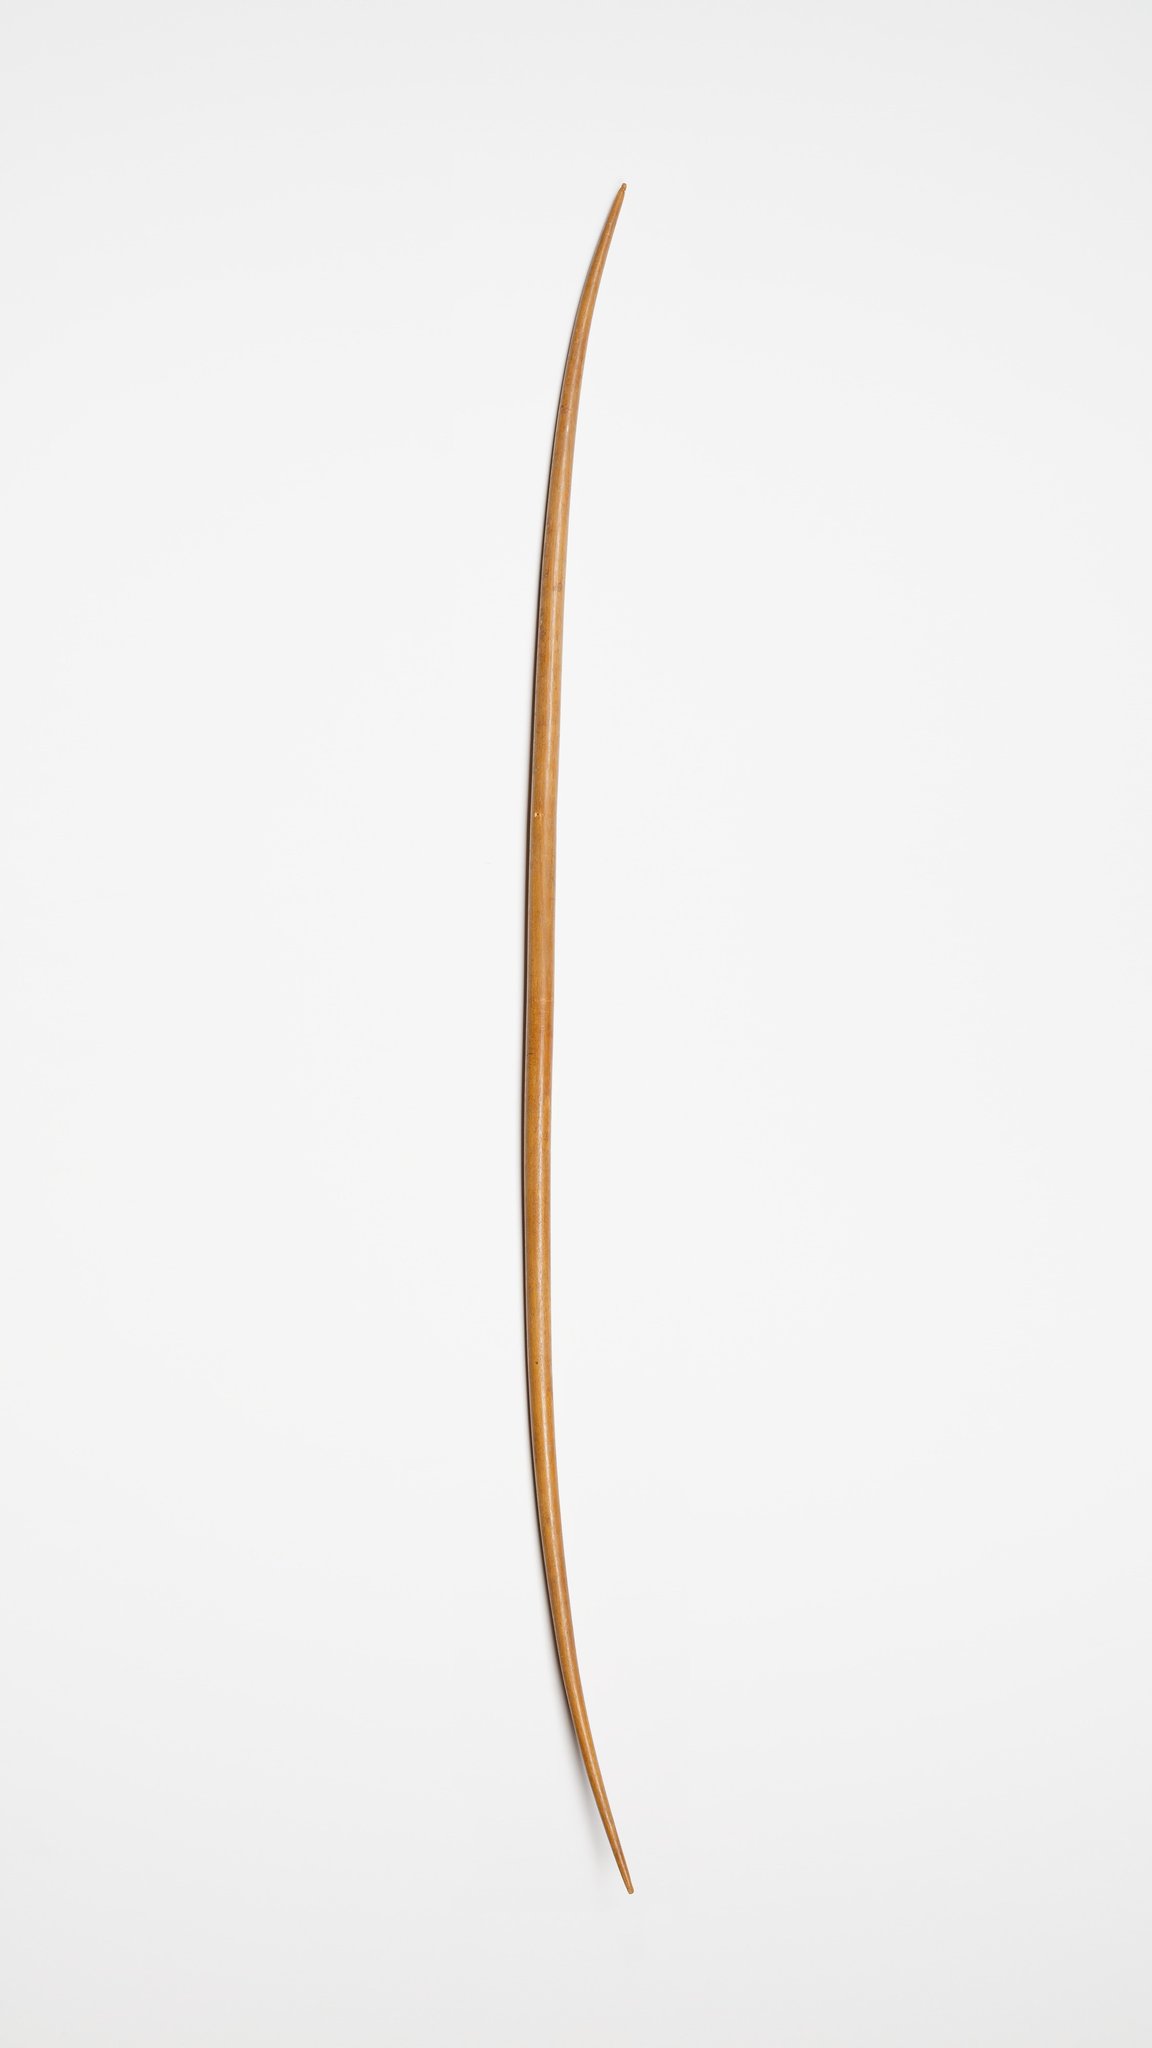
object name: bow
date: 2120-1981 BCE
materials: wood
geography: egypt